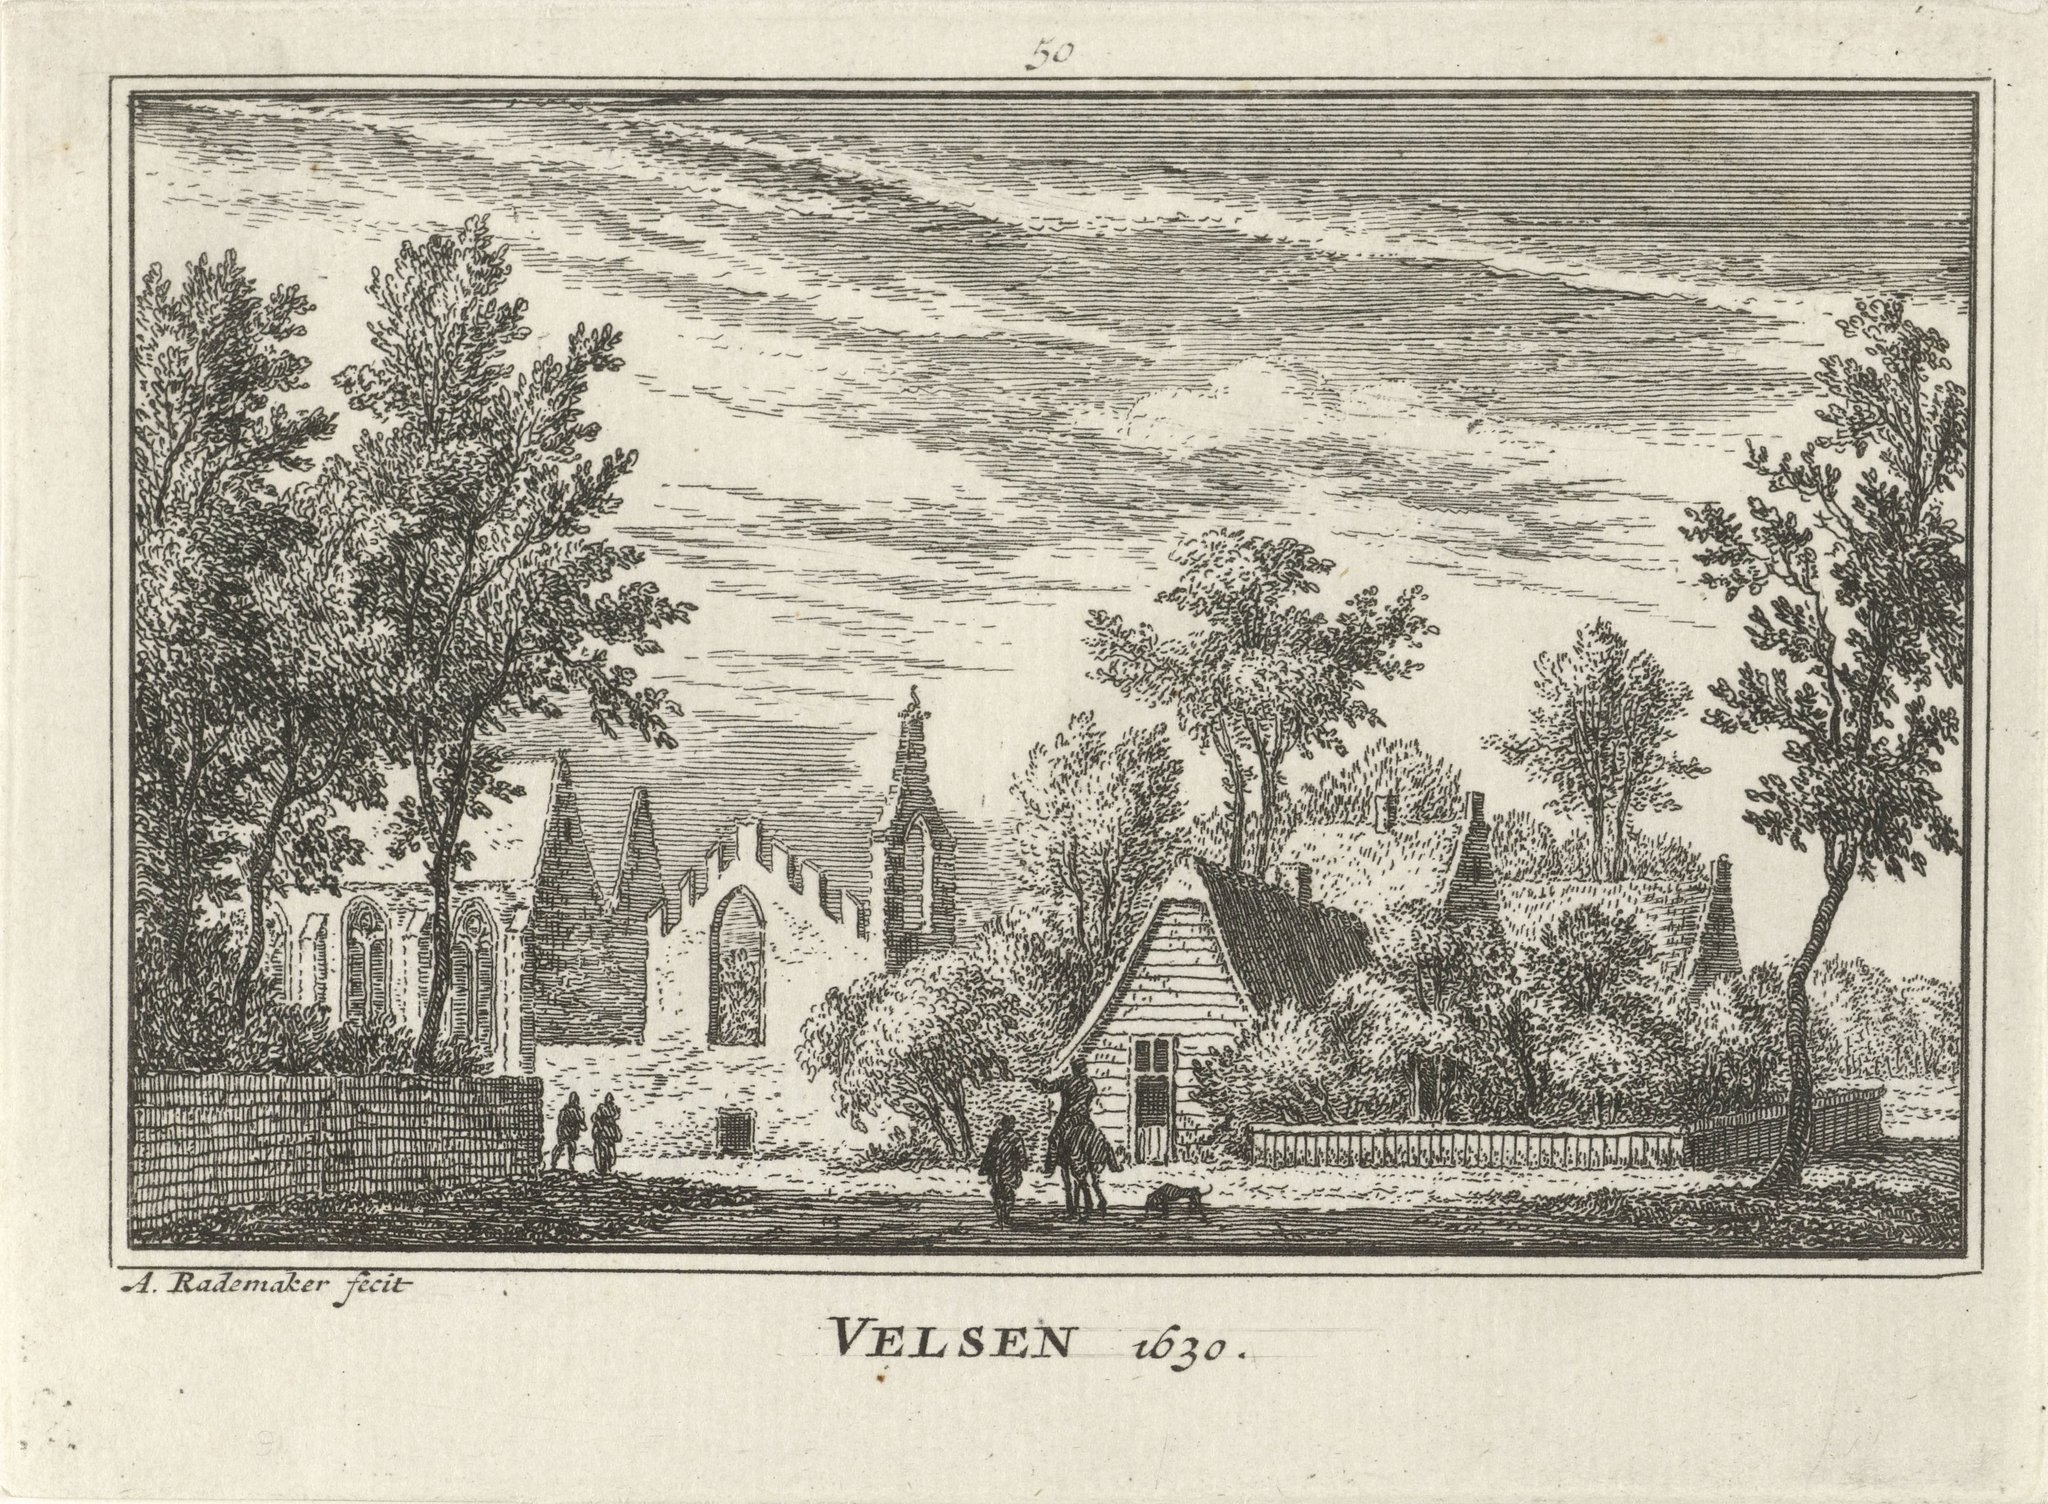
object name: print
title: Gezicht op Velsen, 1630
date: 1727-1733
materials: paper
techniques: etching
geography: amsterdam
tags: church (exterior), dog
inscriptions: collector's mark: Lugt 2228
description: Illustratie uit: Abraham Rademaker, Matthaeus Brouërius van Niedek, Isaac Le Long, Kabinet van Nederlandsche en Kleefsche outheden en (...) voorname stads- en landgebouwen, Willem Barents en Antoni Schoonenburg: Amsterdam, 1727-1733, ill. nr. 50.